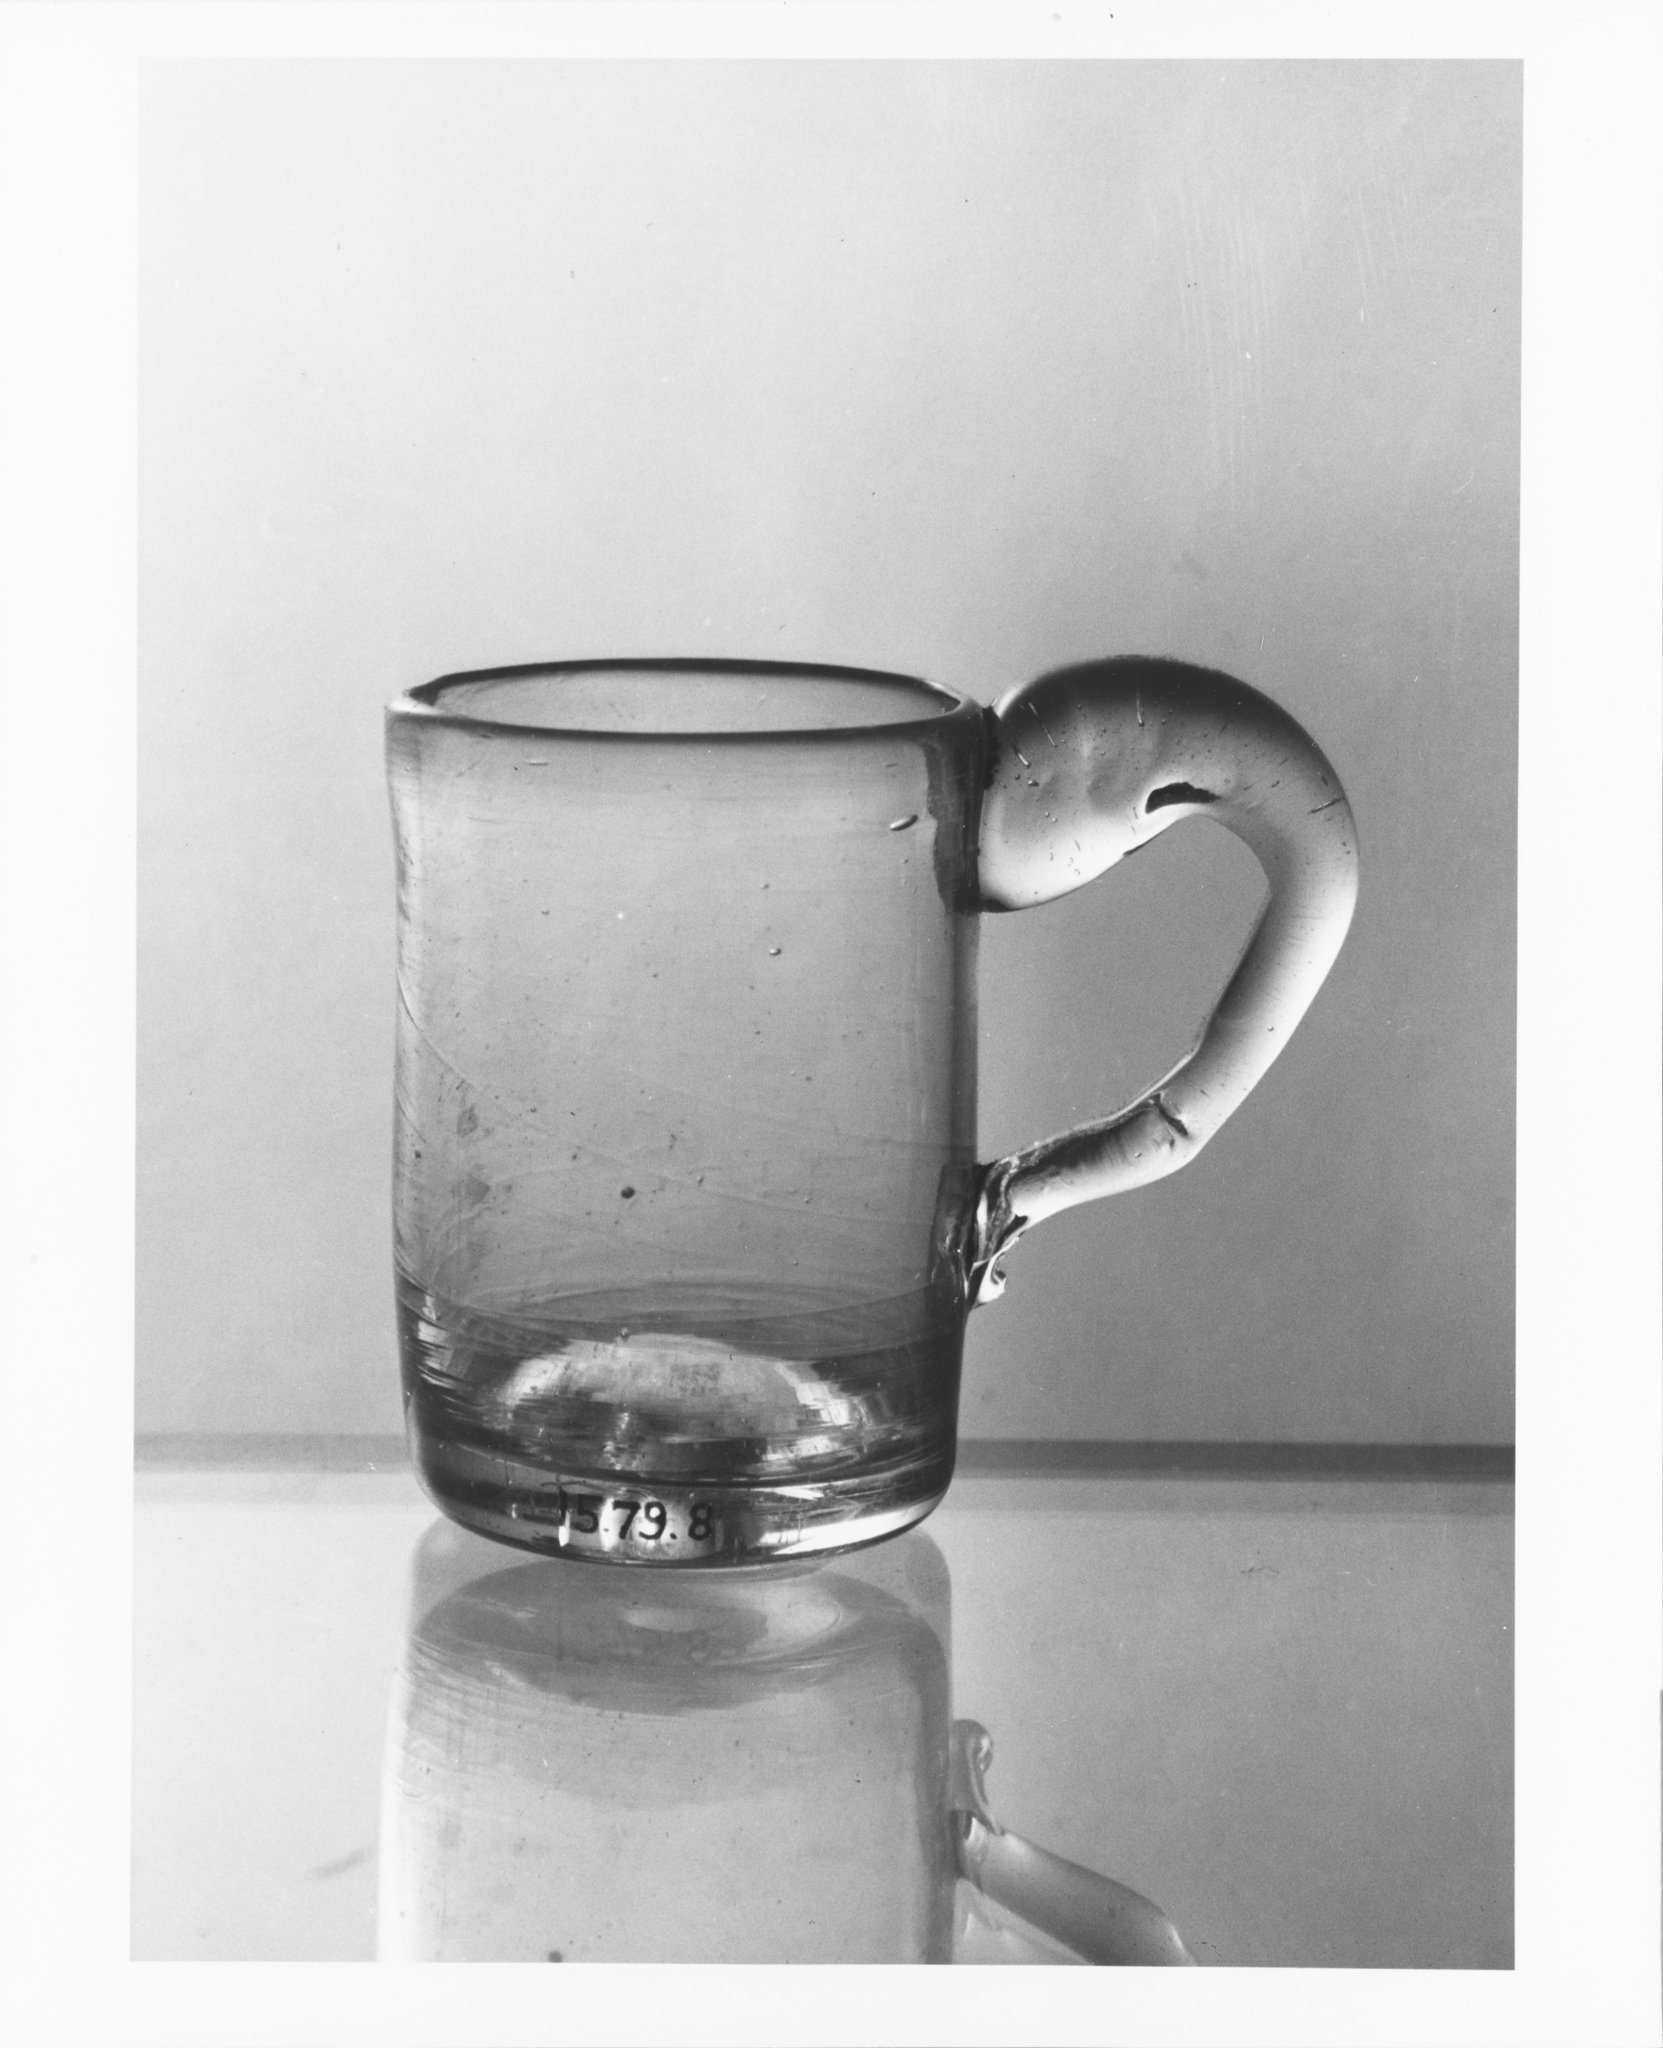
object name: mug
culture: american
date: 1830-1840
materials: gemstone, glass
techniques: glassblowing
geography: united states